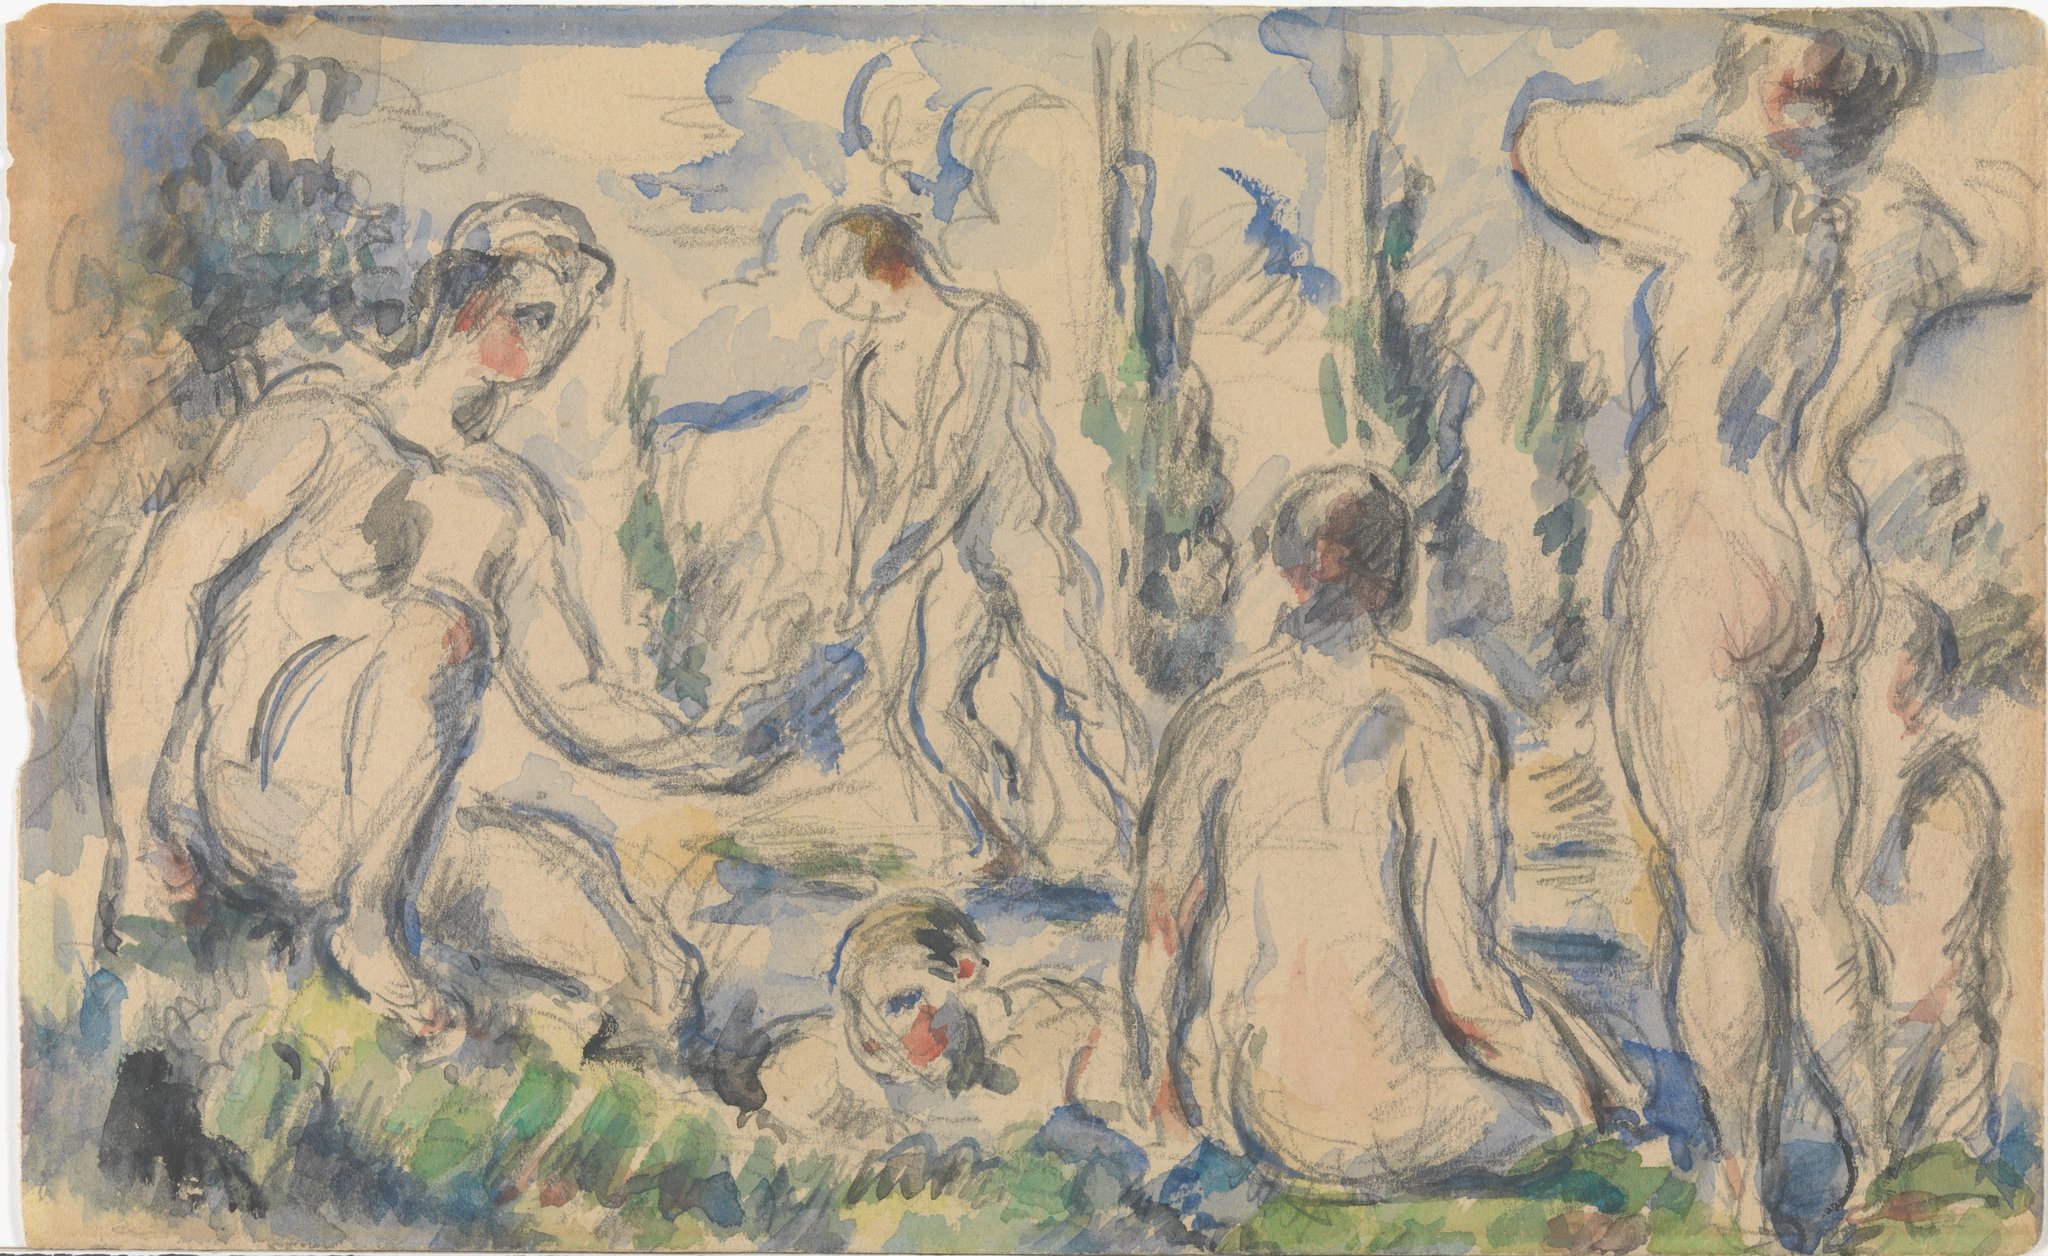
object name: drawing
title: Bathers (recto); Landscape (verso)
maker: paul cézanne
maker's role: artist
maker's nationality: french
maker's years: 1839-1906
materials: graphite, watercolor, paper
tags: bathing